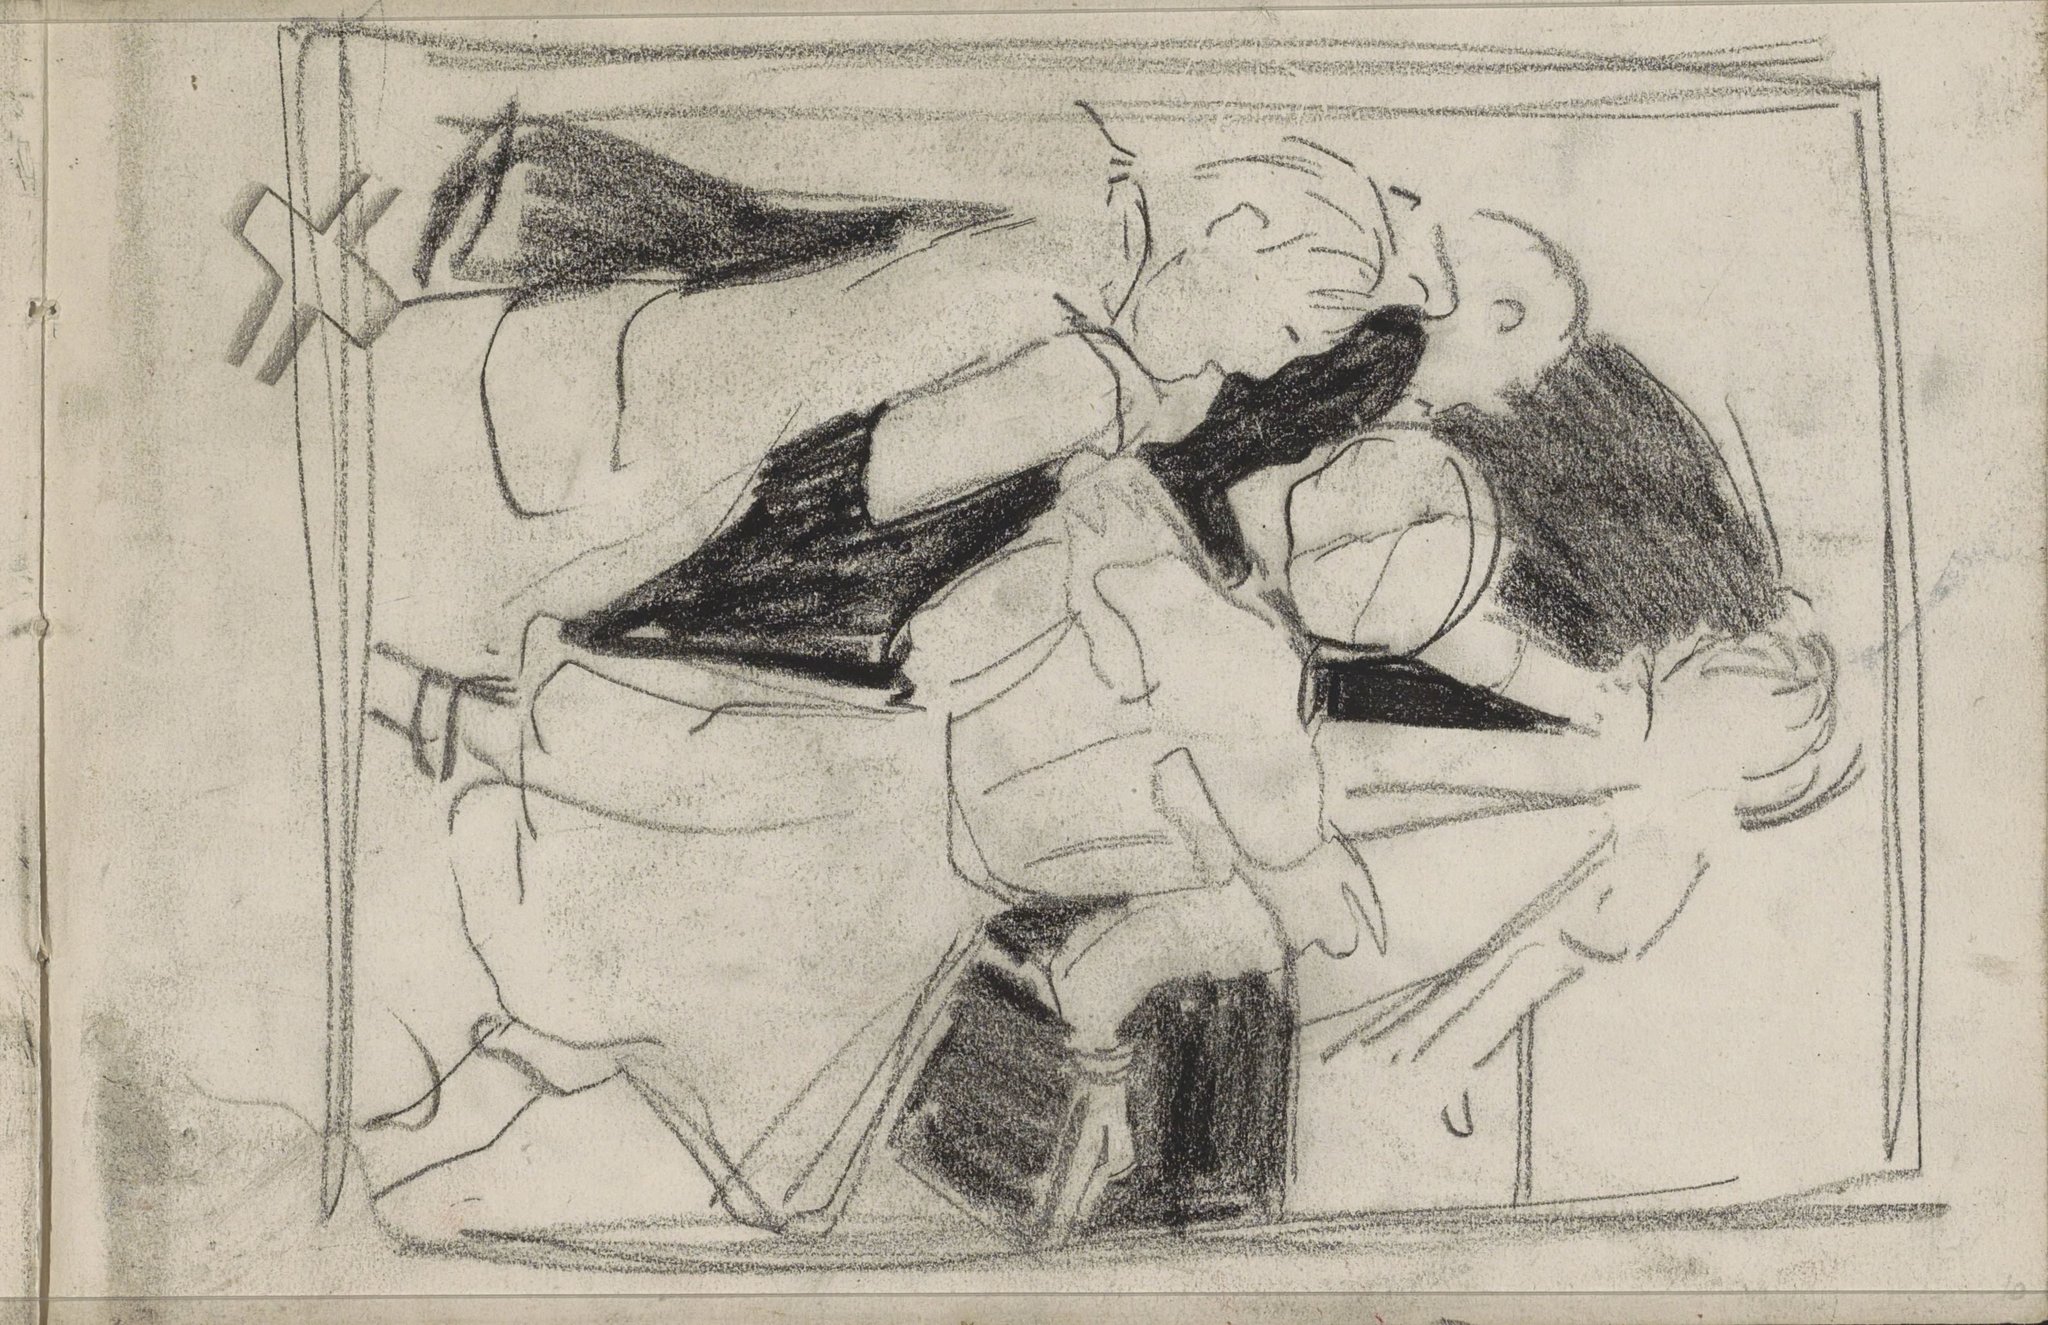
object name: sketchbook leaf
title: Kinderen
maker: carel adolph lion cachet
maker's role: draughtsman, print maker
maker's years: 1864-1945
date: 1895-1900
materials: chalk, paper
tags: child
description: Blad 10 recto uit een schetsboek met 19 bladen.